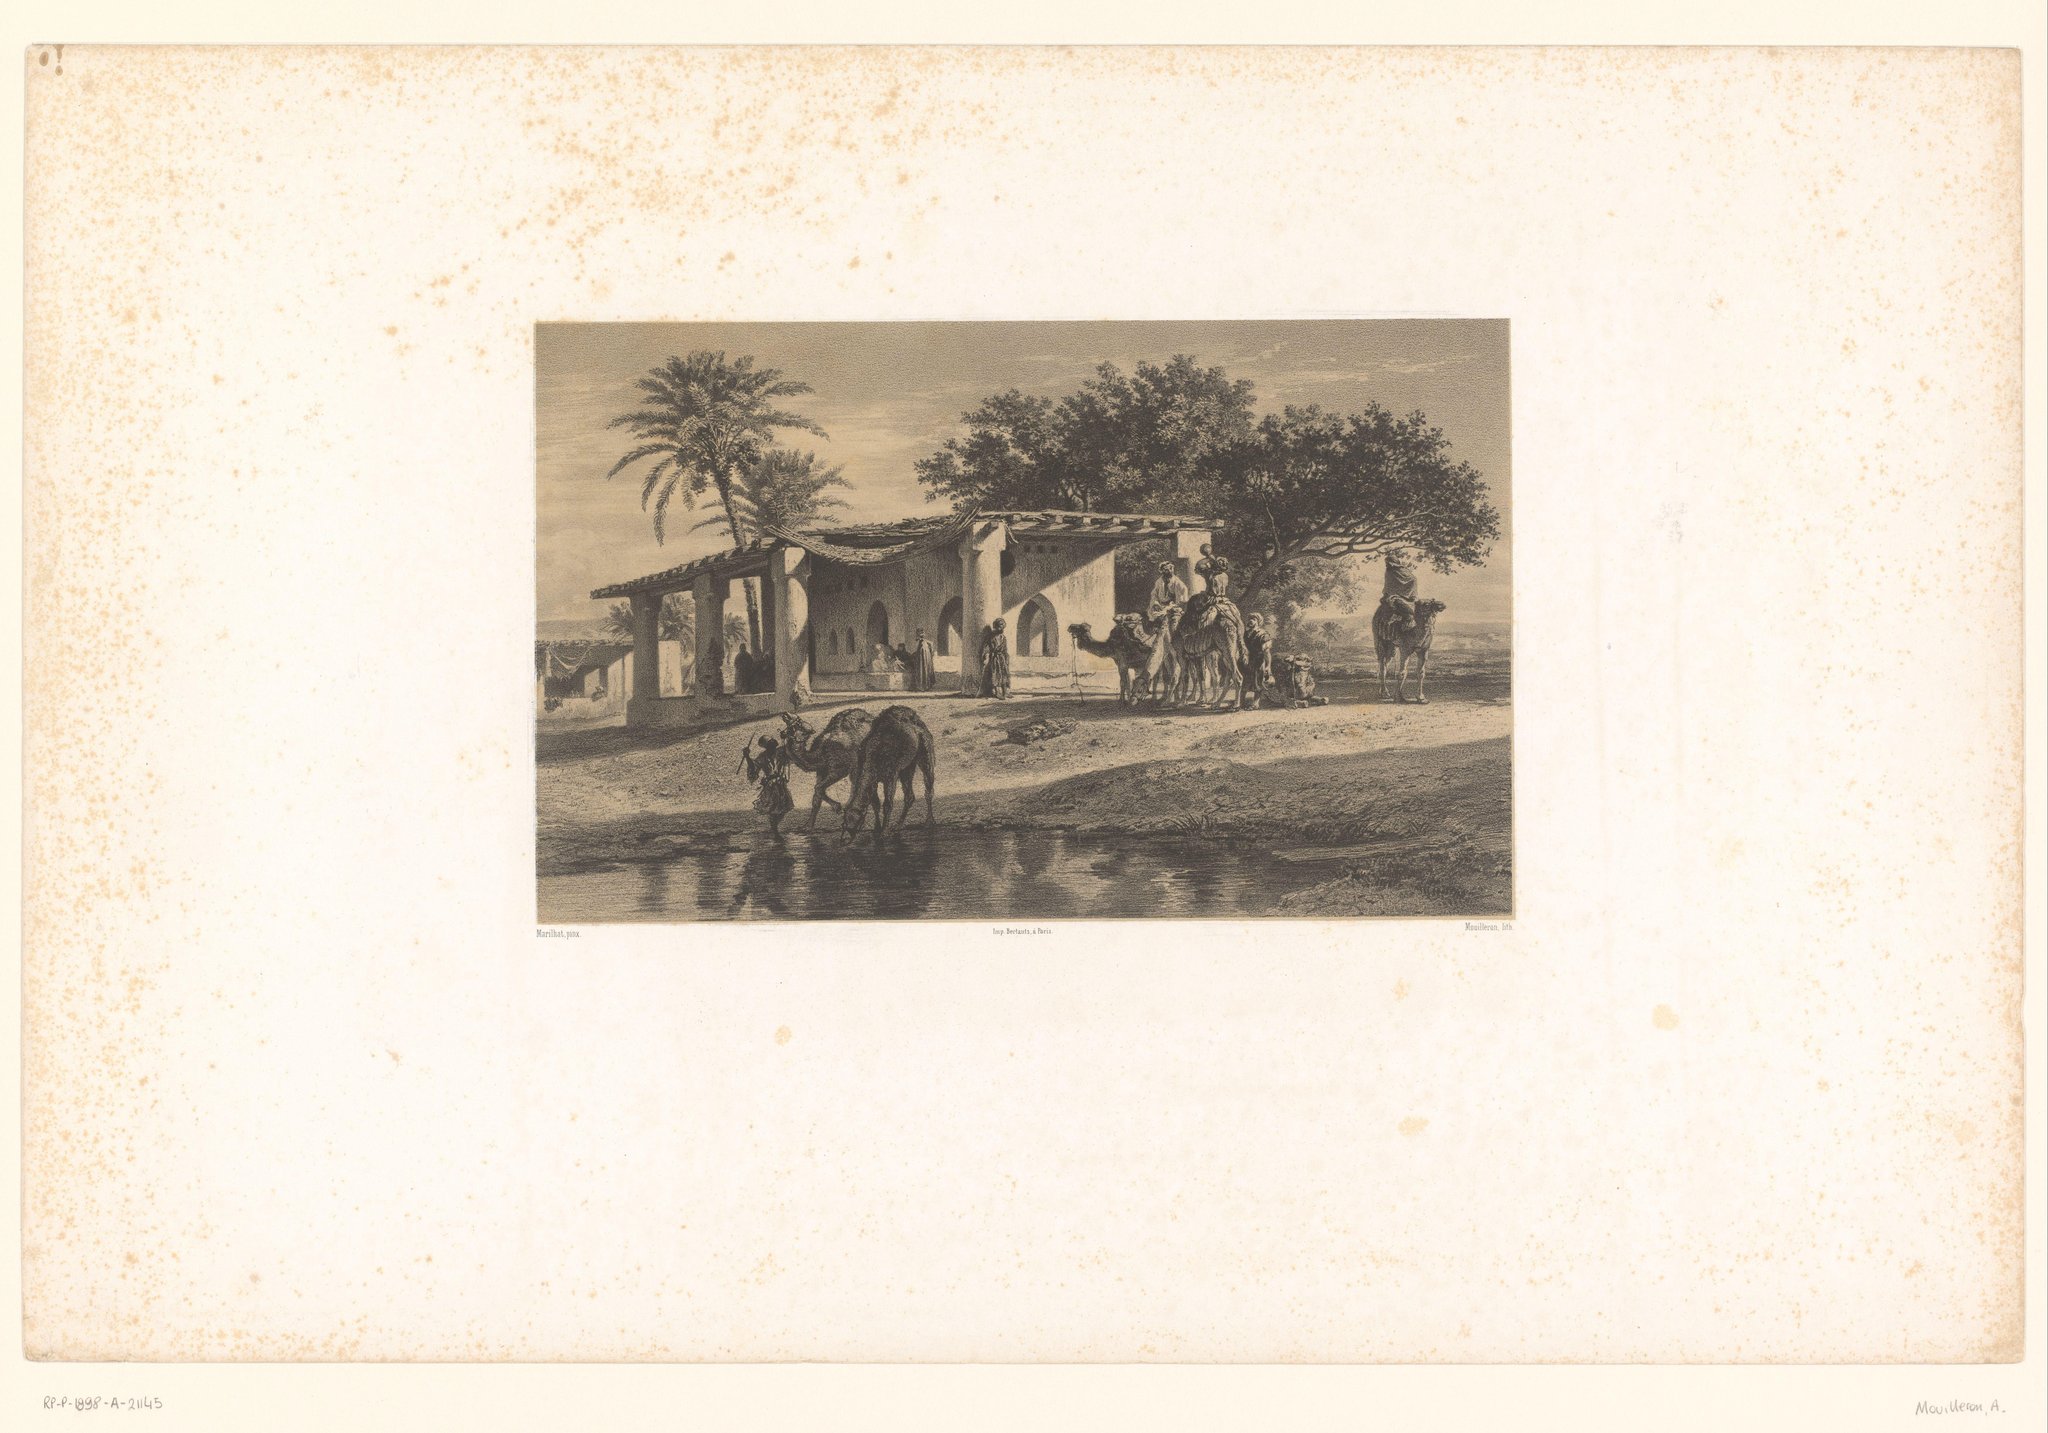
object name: print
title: Karavaan rust uit bij water en bebouwing in woestijnlandschap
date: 1830-1880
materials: paper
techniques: lithograph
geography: paris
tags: hoofed animals: camel, resting - bb - out of doors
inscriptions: collector's mark: Lugt 964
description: Prent mogelijk verschenen in de prentserie 'L'orient artistique et pittoresque'. Deze serie bestaat uit een onbekend aantal prenten.